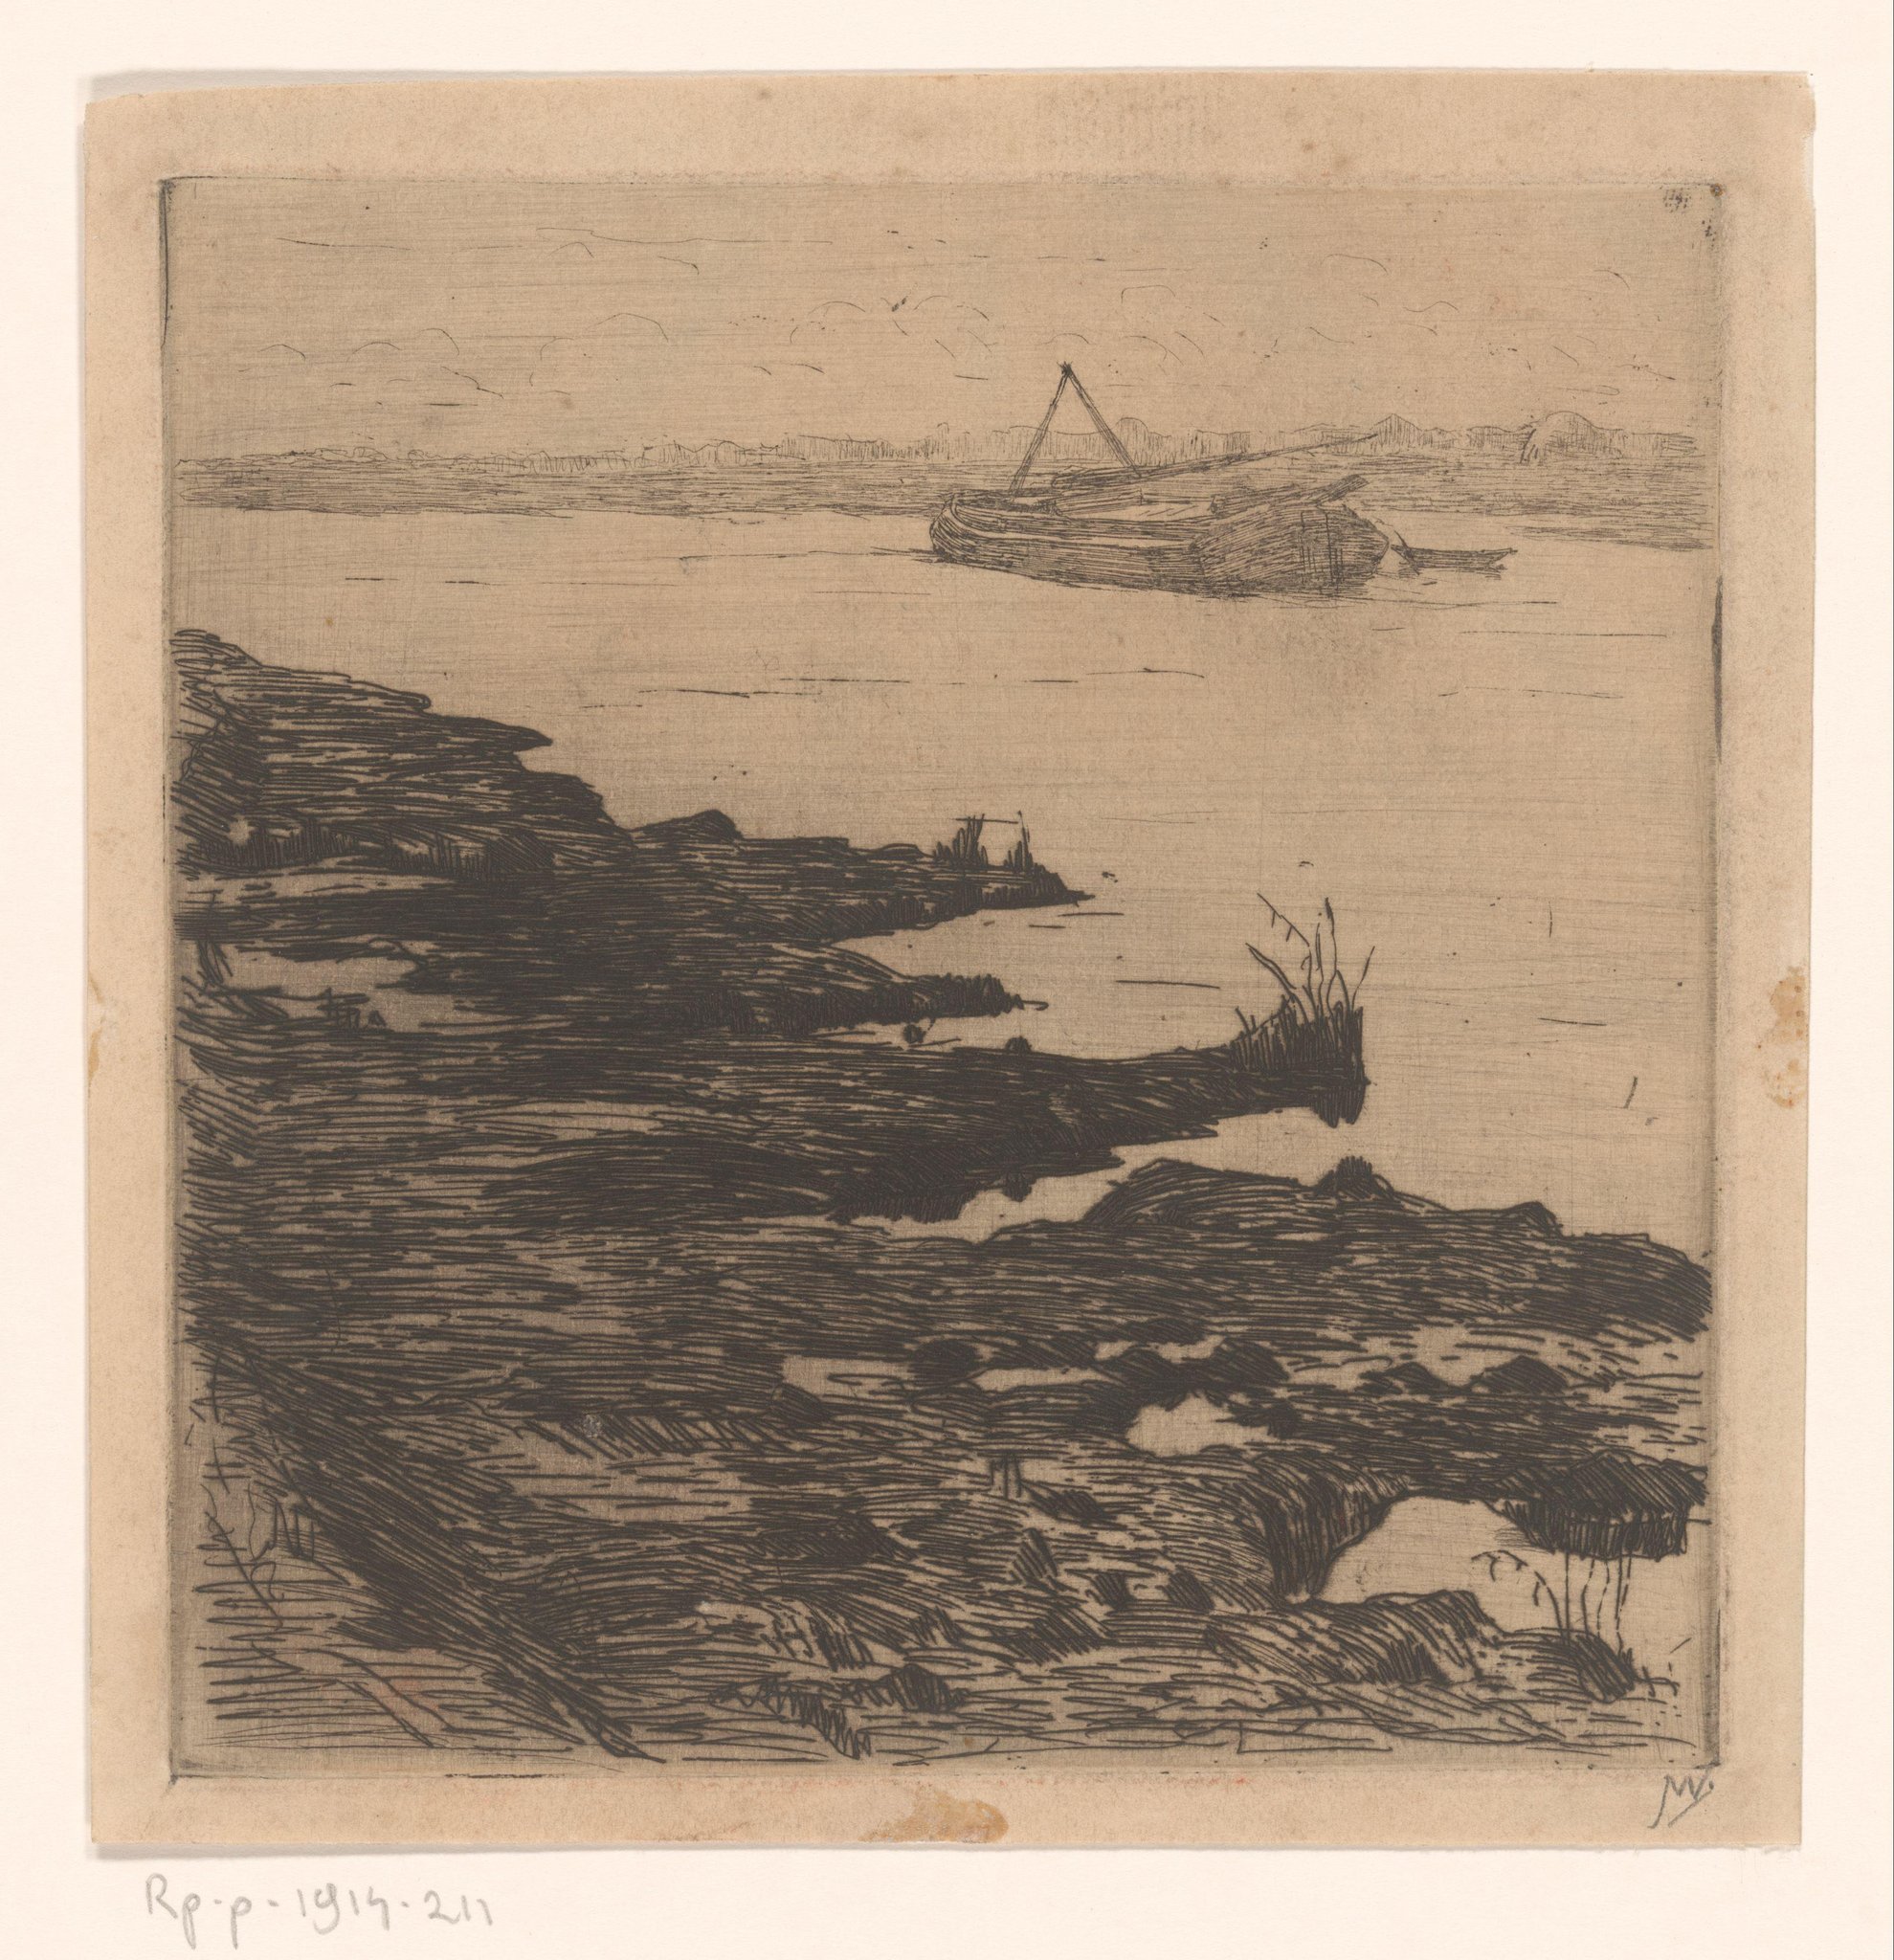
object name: print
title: Rivier met boot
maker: maurits van der valk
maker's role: draughtsman, print maker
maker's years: 1857-1935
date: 1867-1914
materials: paper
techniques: drypoint, etching, intaglio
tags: river, freight vessel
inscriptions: collector's mark: Lugt 2233